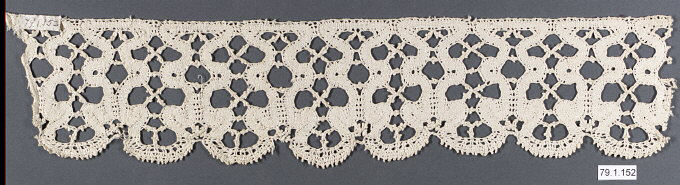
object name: fragment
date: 1601-1700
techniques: lace